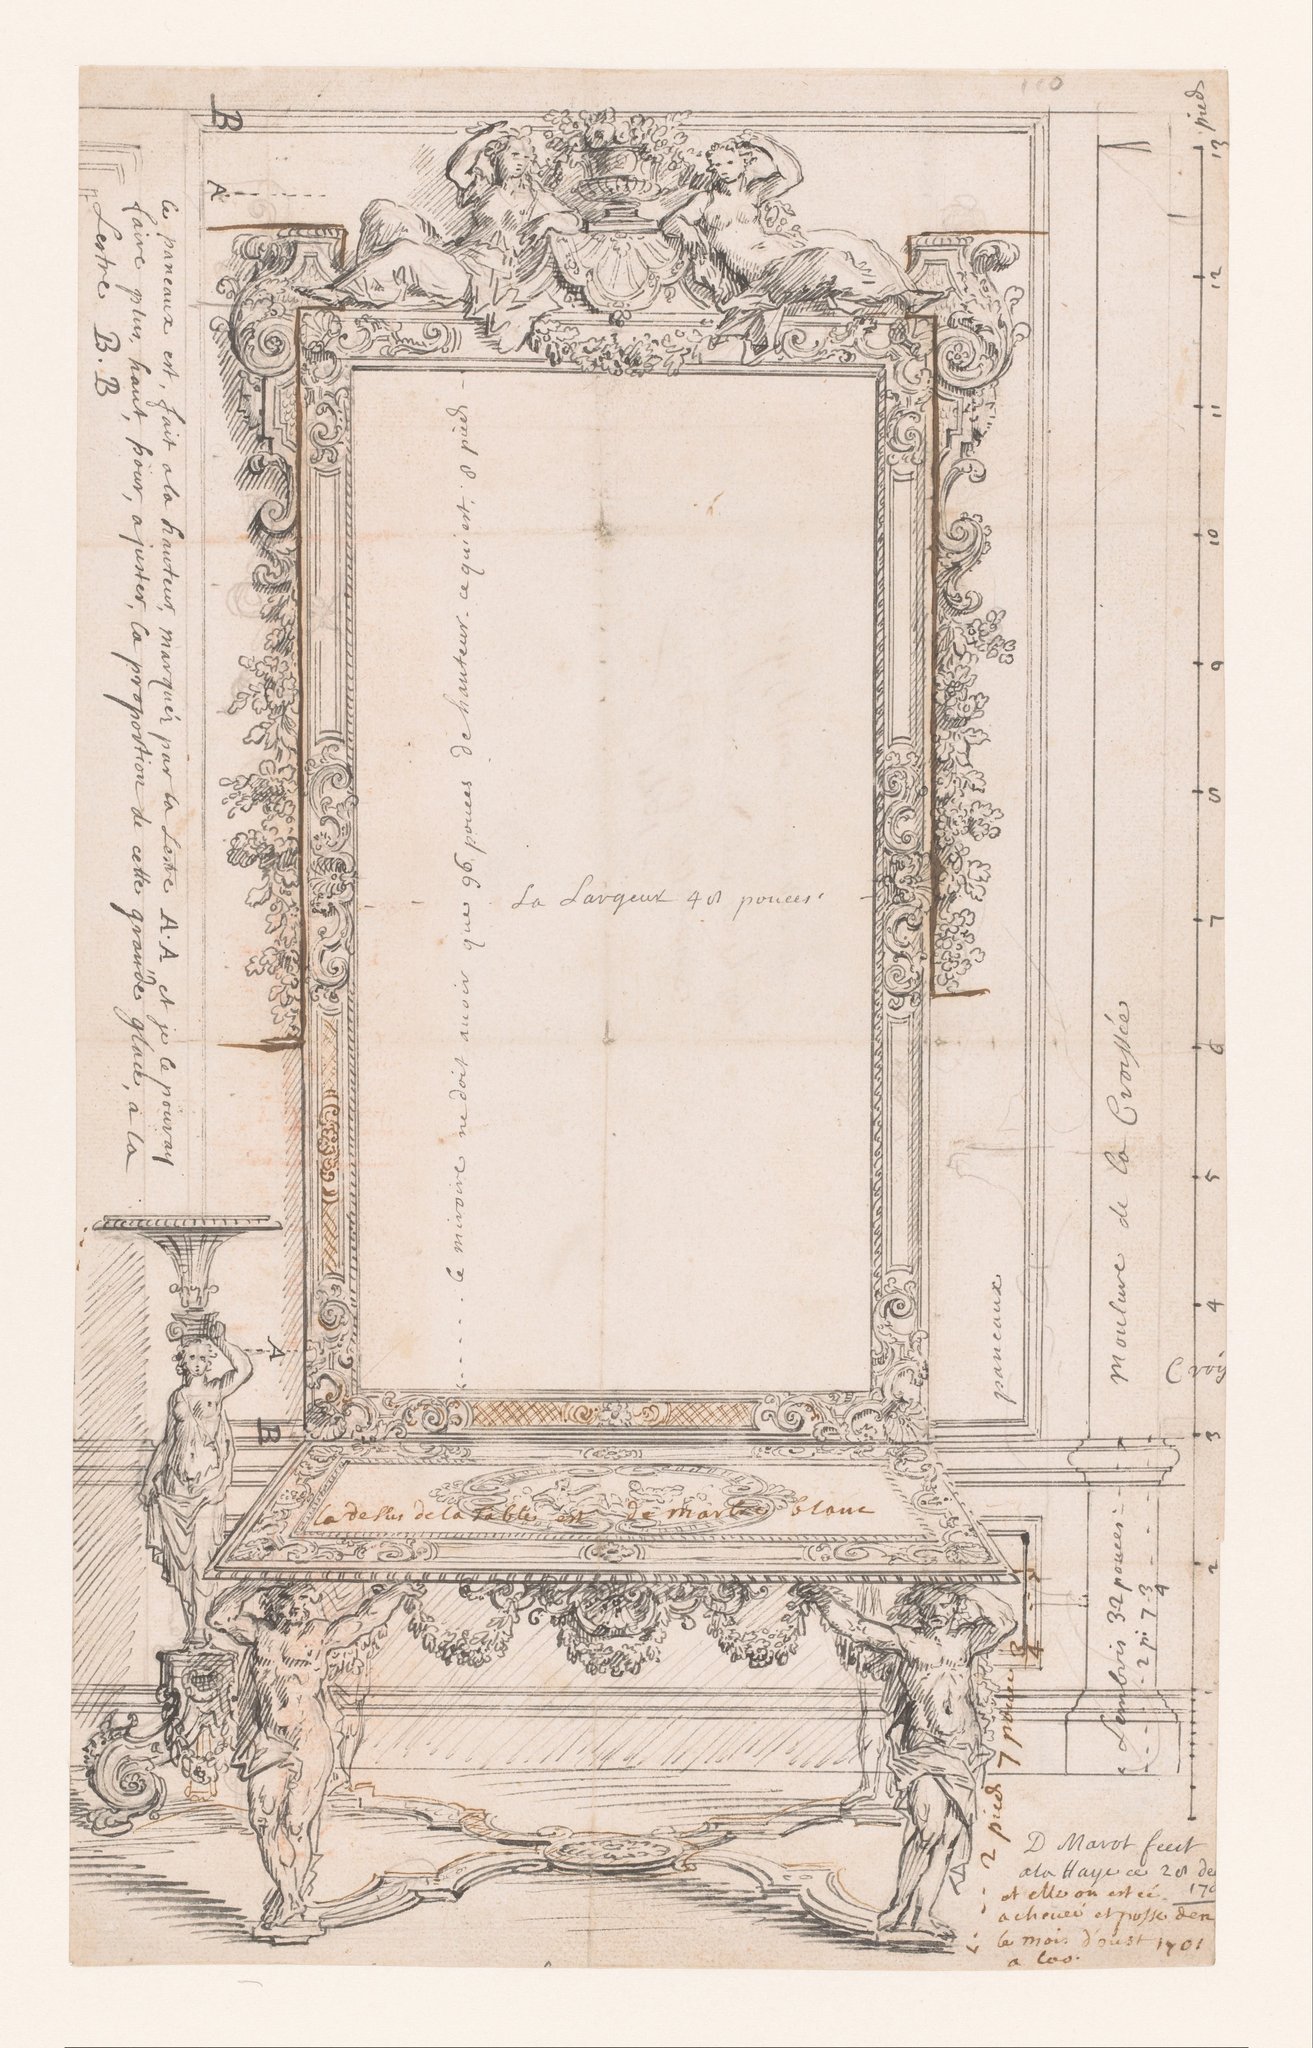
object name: design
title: Ontwerp voor een spiegel met penanttafel en guéridons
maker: daniël marot (i)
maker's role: draughtsman, print maker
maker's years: 1661-1752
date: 1700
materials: chalk, ink, paper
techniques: pen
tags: mirror, table, furniture to put things on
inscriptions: date: ‘170[0]’